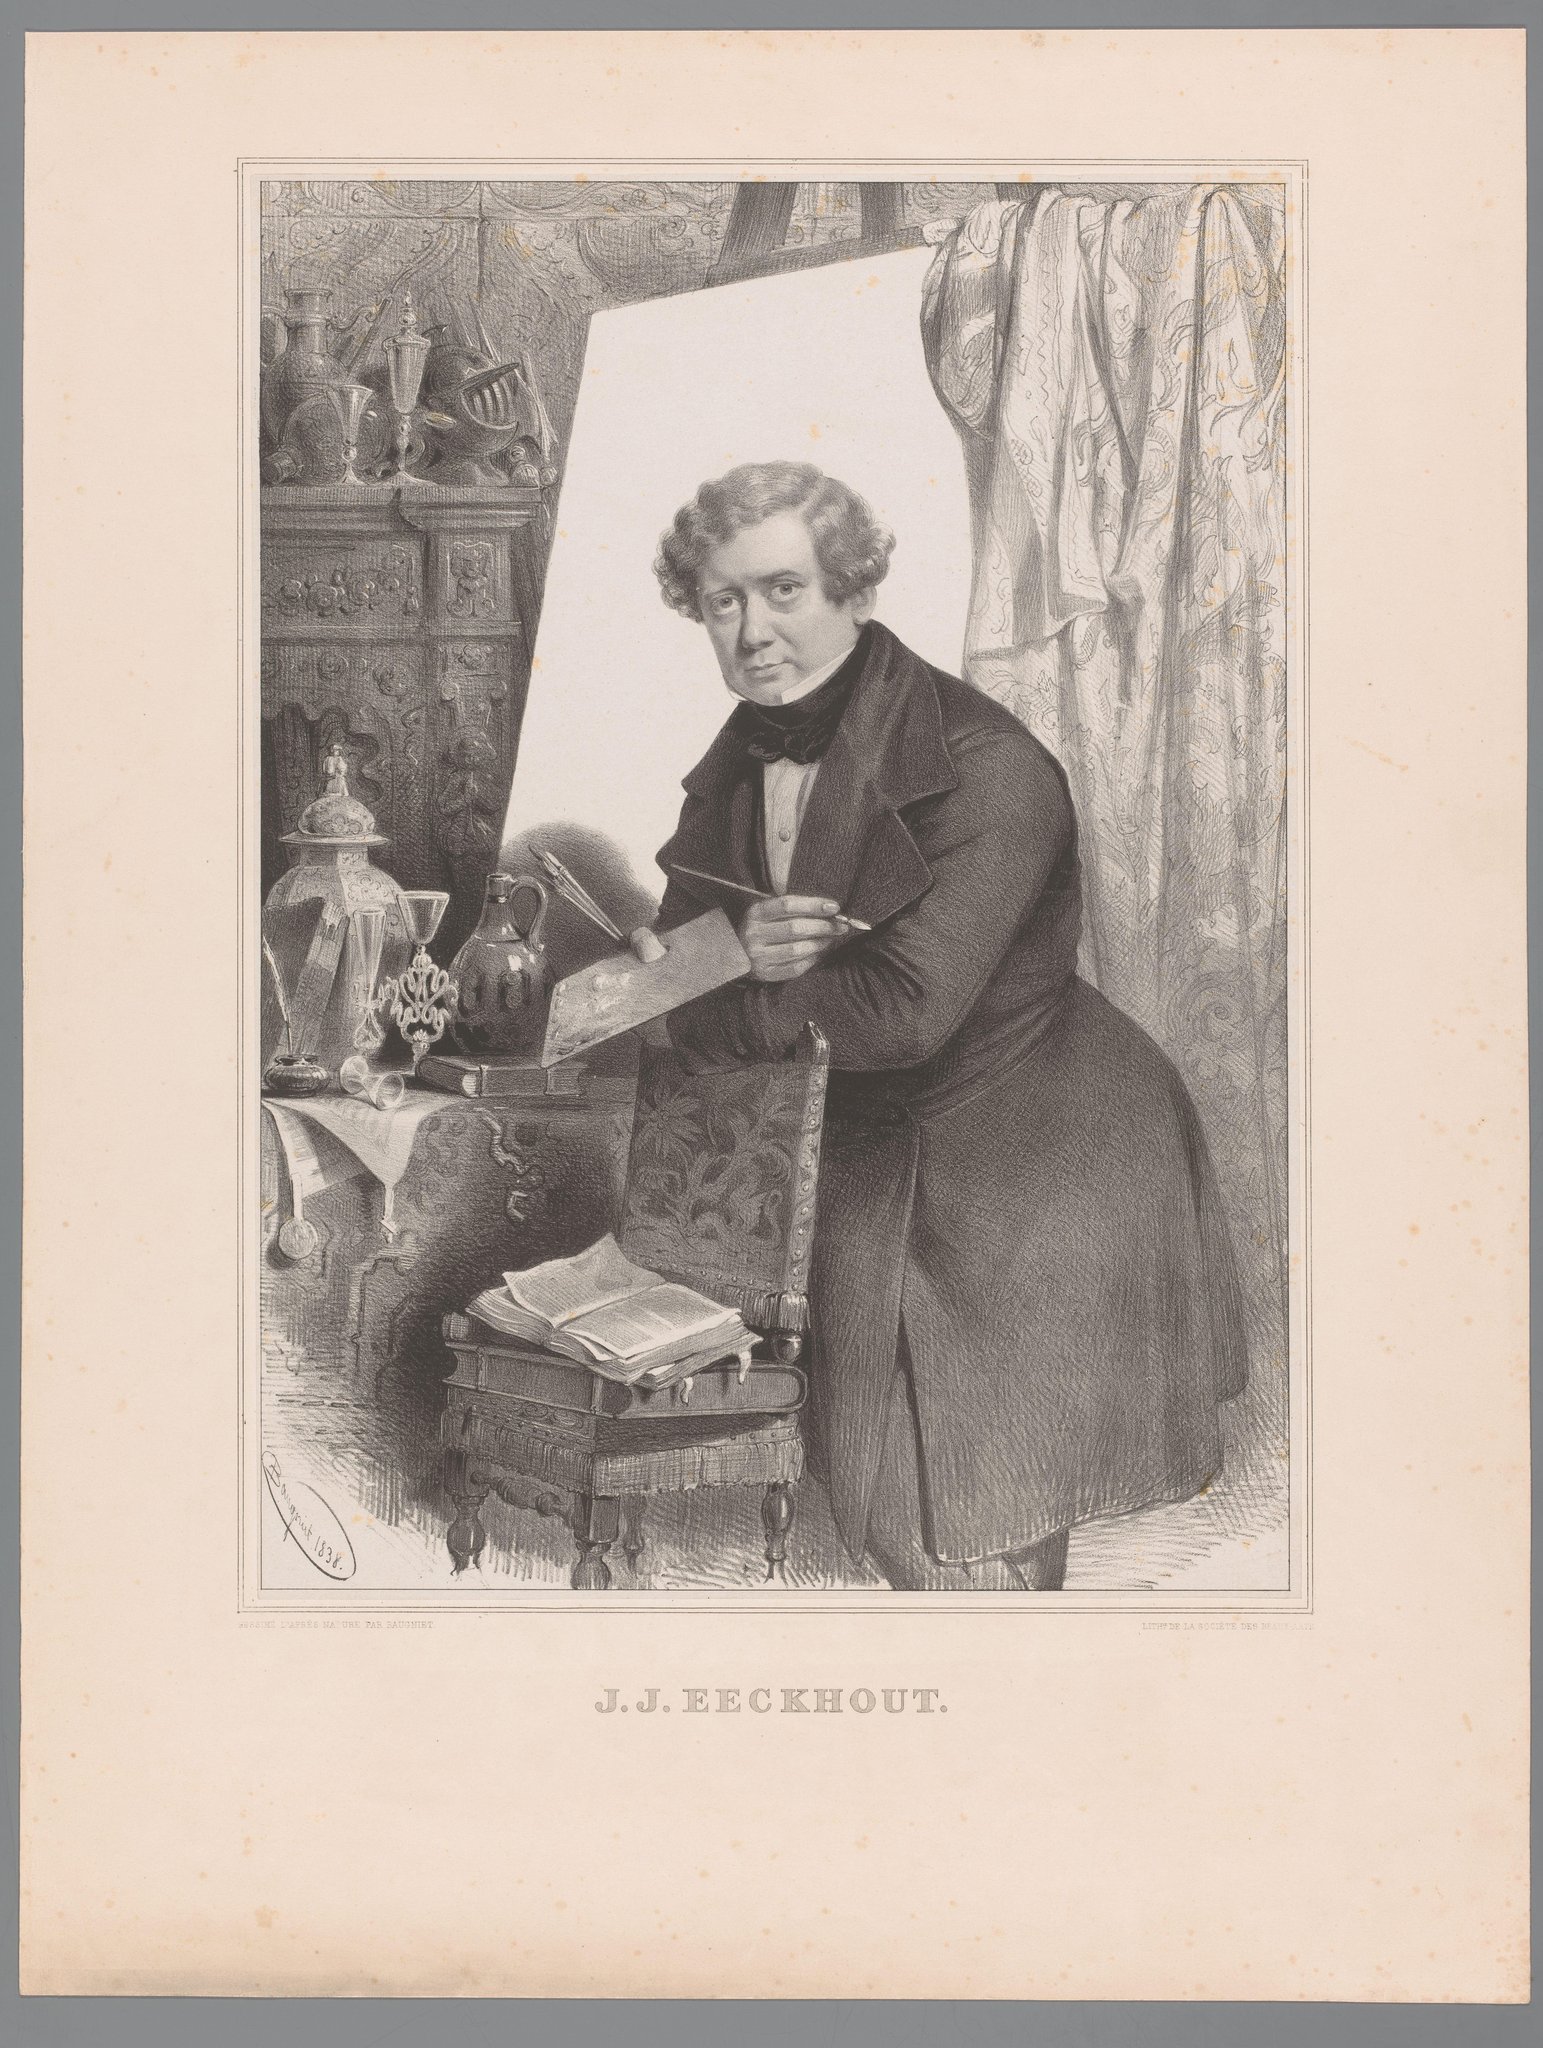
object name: print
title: J.J. Eeckhout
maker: charles baugniet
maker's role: print maker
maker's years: 1814-1886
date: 1838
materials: paper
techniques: lithograph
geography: brussels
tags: antwerp, paris, print maker, draughtsman, jacob joseph eeckhout, adult man, historical persons, portrait, self-portrait of painter, interior of the house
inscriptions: date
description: Andere staat verschenen in: Baugniet, Charles. Les artistes contemporains: portraits lithographiés d'après nature, accompagnés de notices sur la vie et les ouvrages de chacun d'eux. Brussel: De Wasme-Pletinckx, [1836-1840].